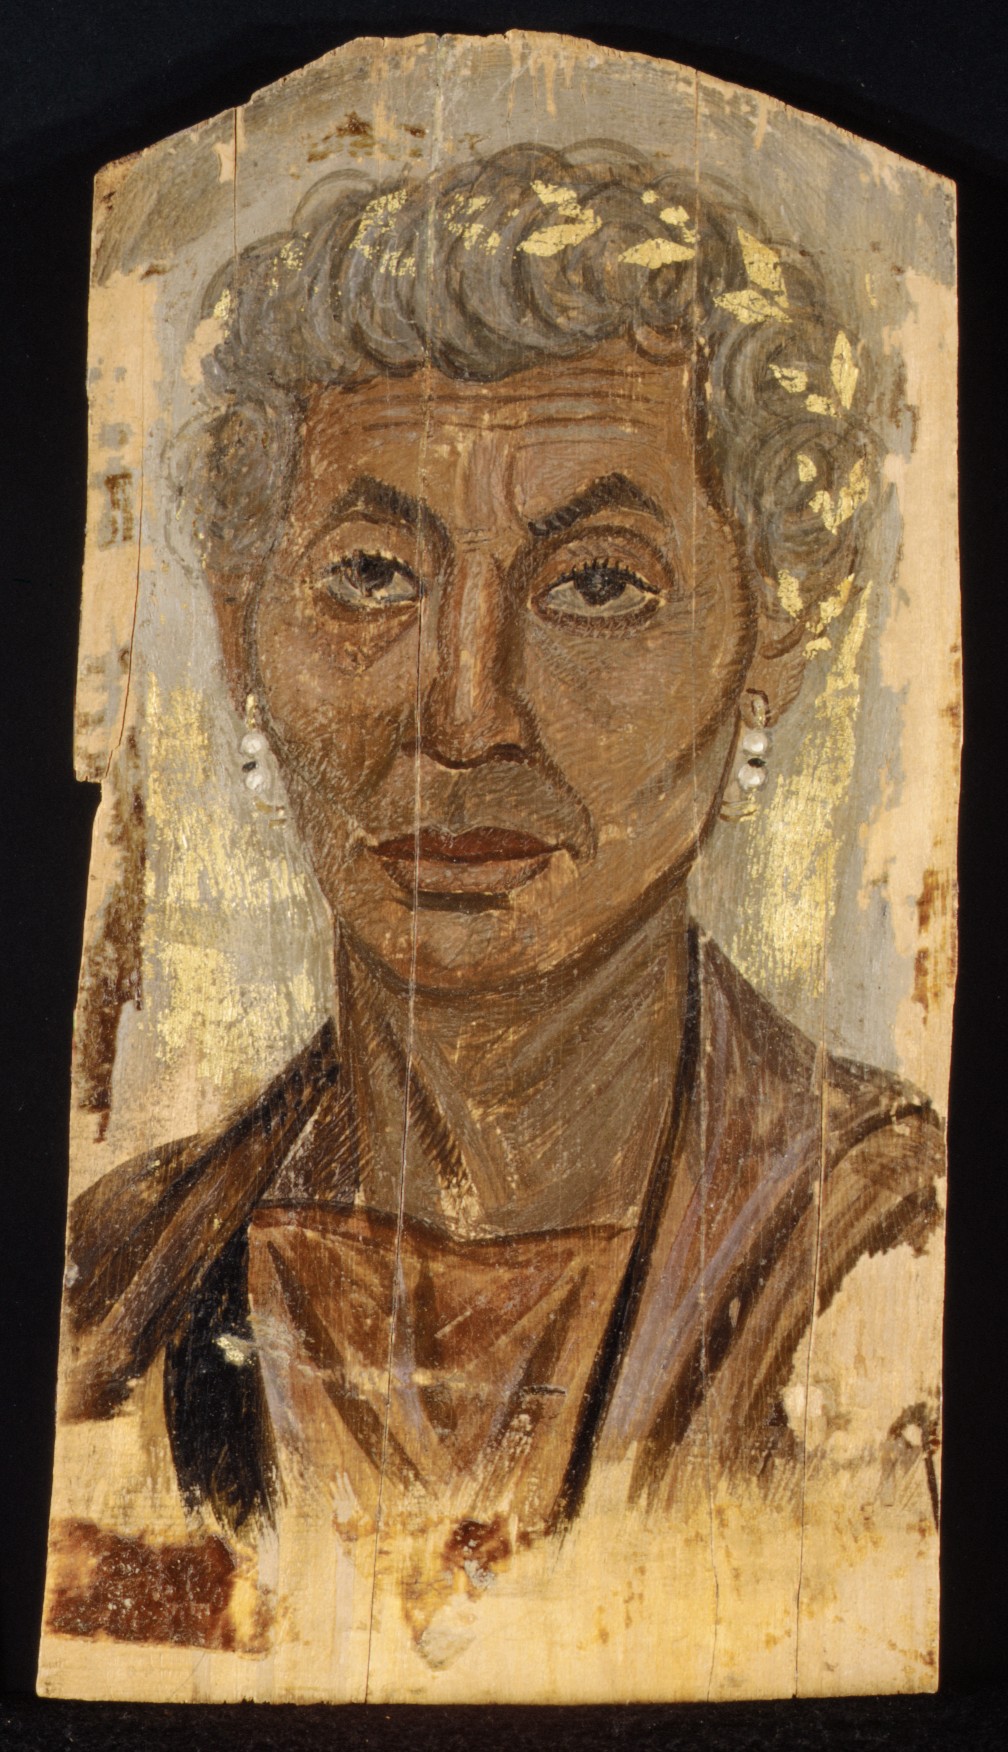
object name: panel painting, elderly lady with a gold wreath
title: Portrait of an elderly lady with a gold wreath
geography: egypt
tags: portraits,women